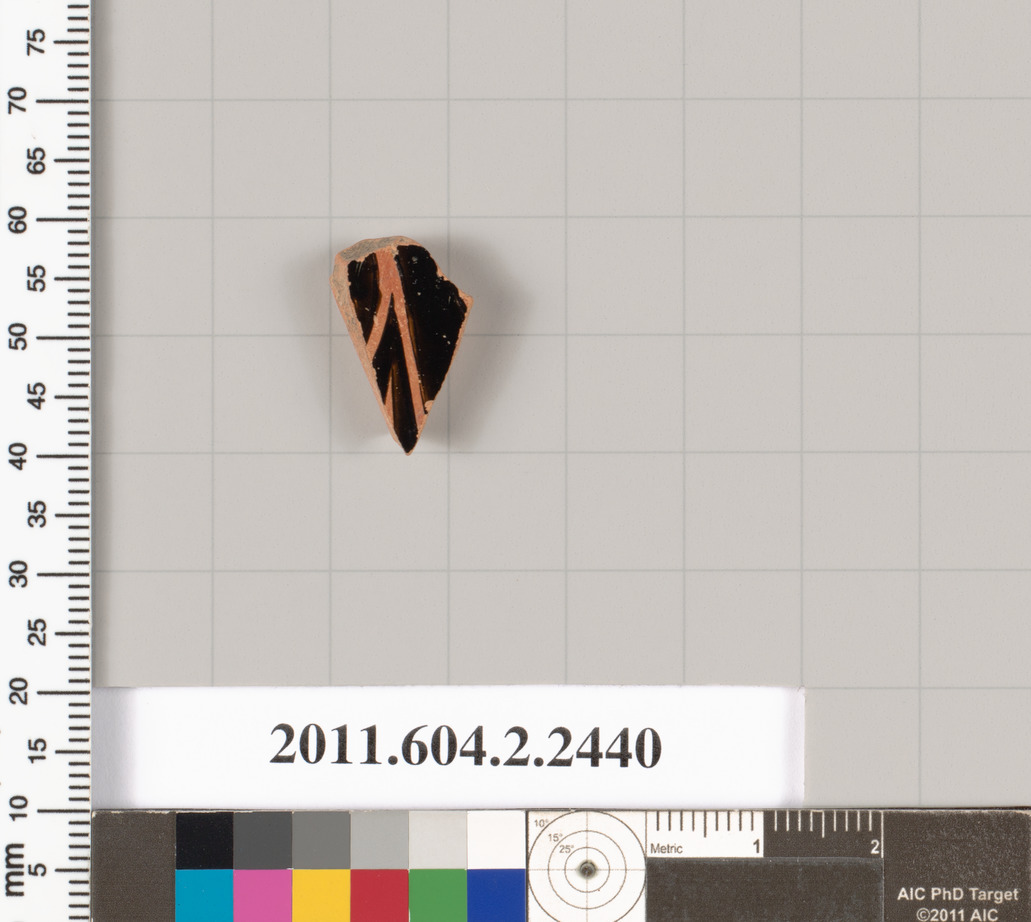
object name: skyphos fragment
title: Terracotta fragment of skyphos (deep drinking cup)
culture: greek, attic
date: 500-401 BCE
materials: terracotta